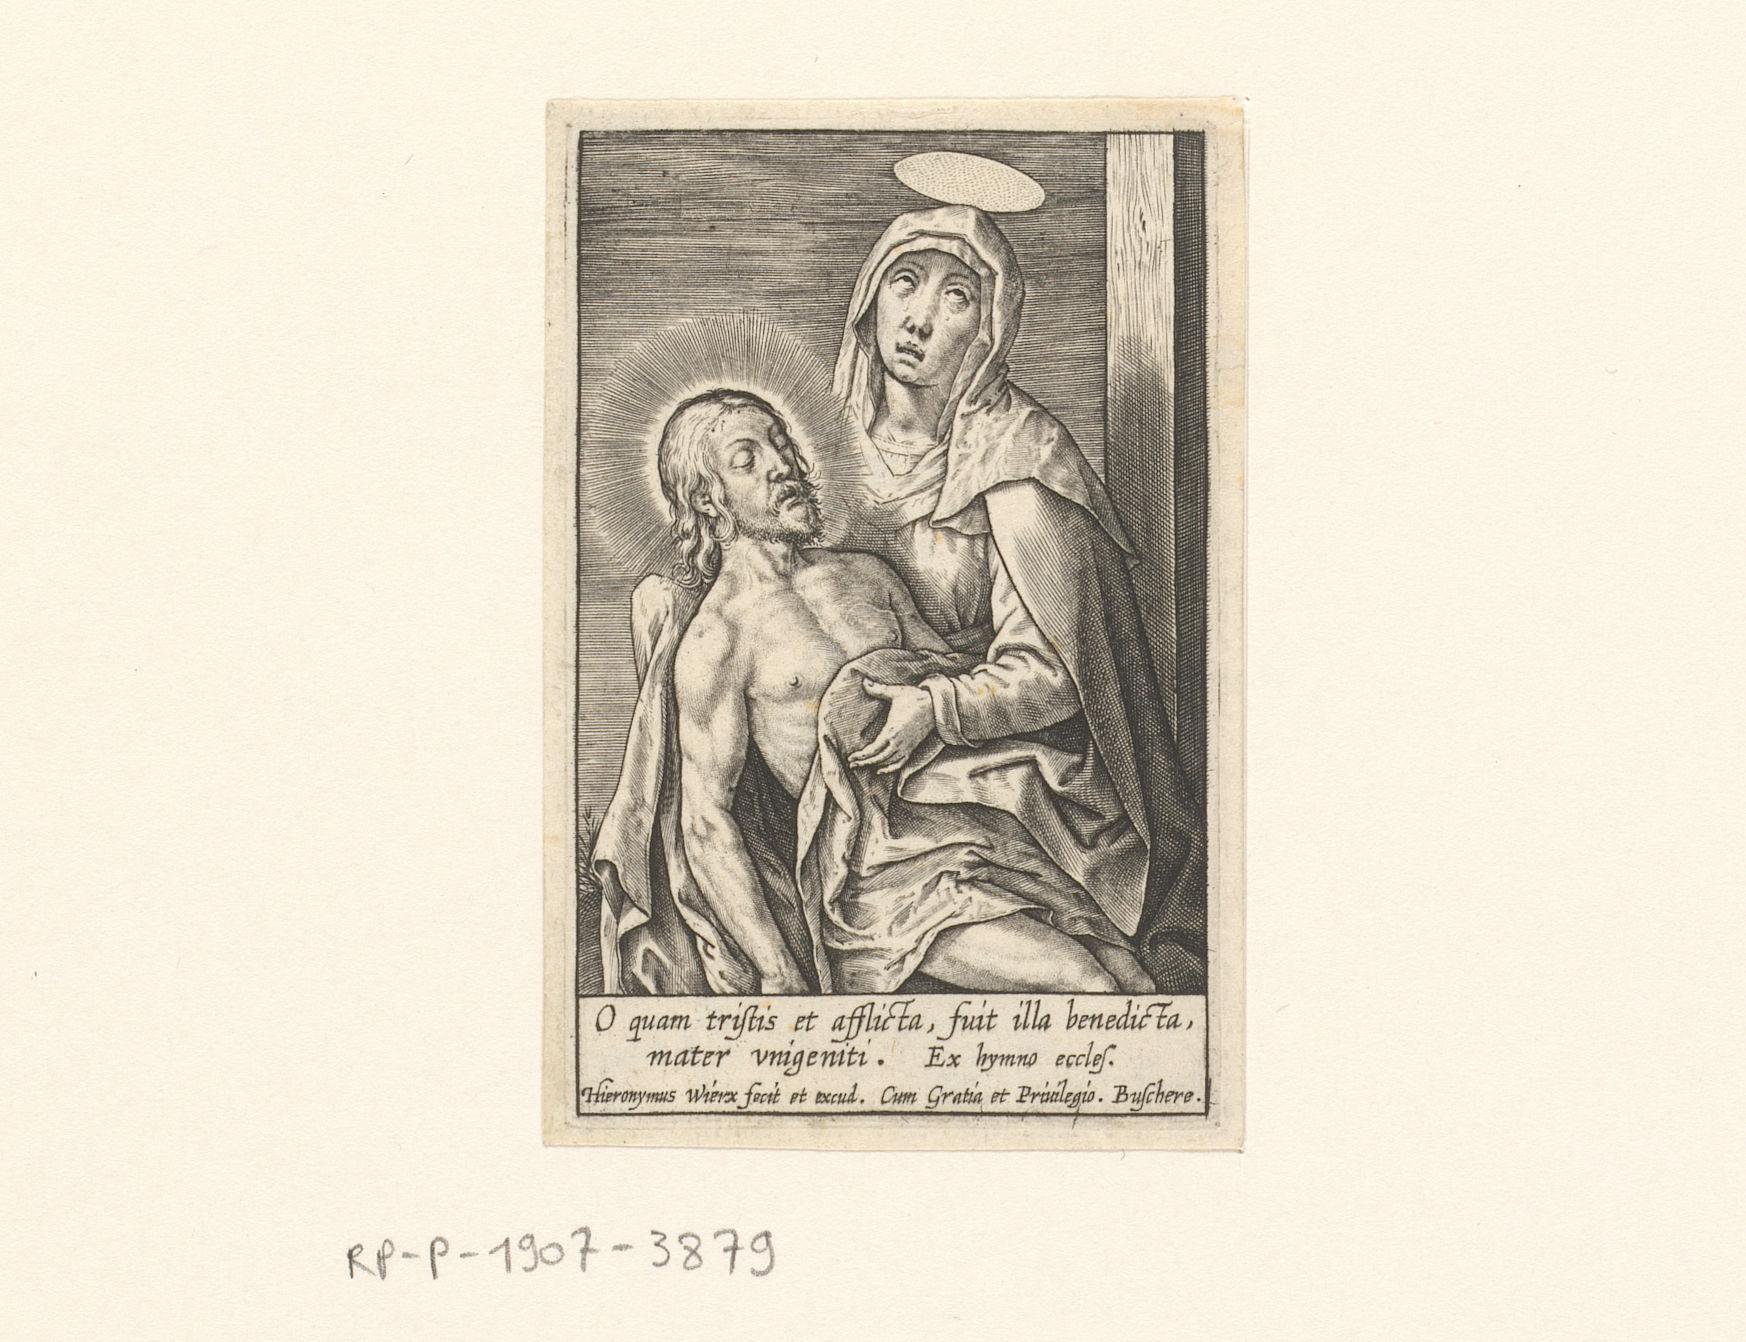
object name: print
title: Piëta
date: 1595-1619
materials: paper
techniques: engraving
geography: antwerp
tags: the dead christ in mary's lap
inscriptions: inscription: ‘AP 416’, collector's mark: Lugt 2542, collector's mark: Lugt 2228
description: In de marge een tweeregelig onderschrift in het Latijn.